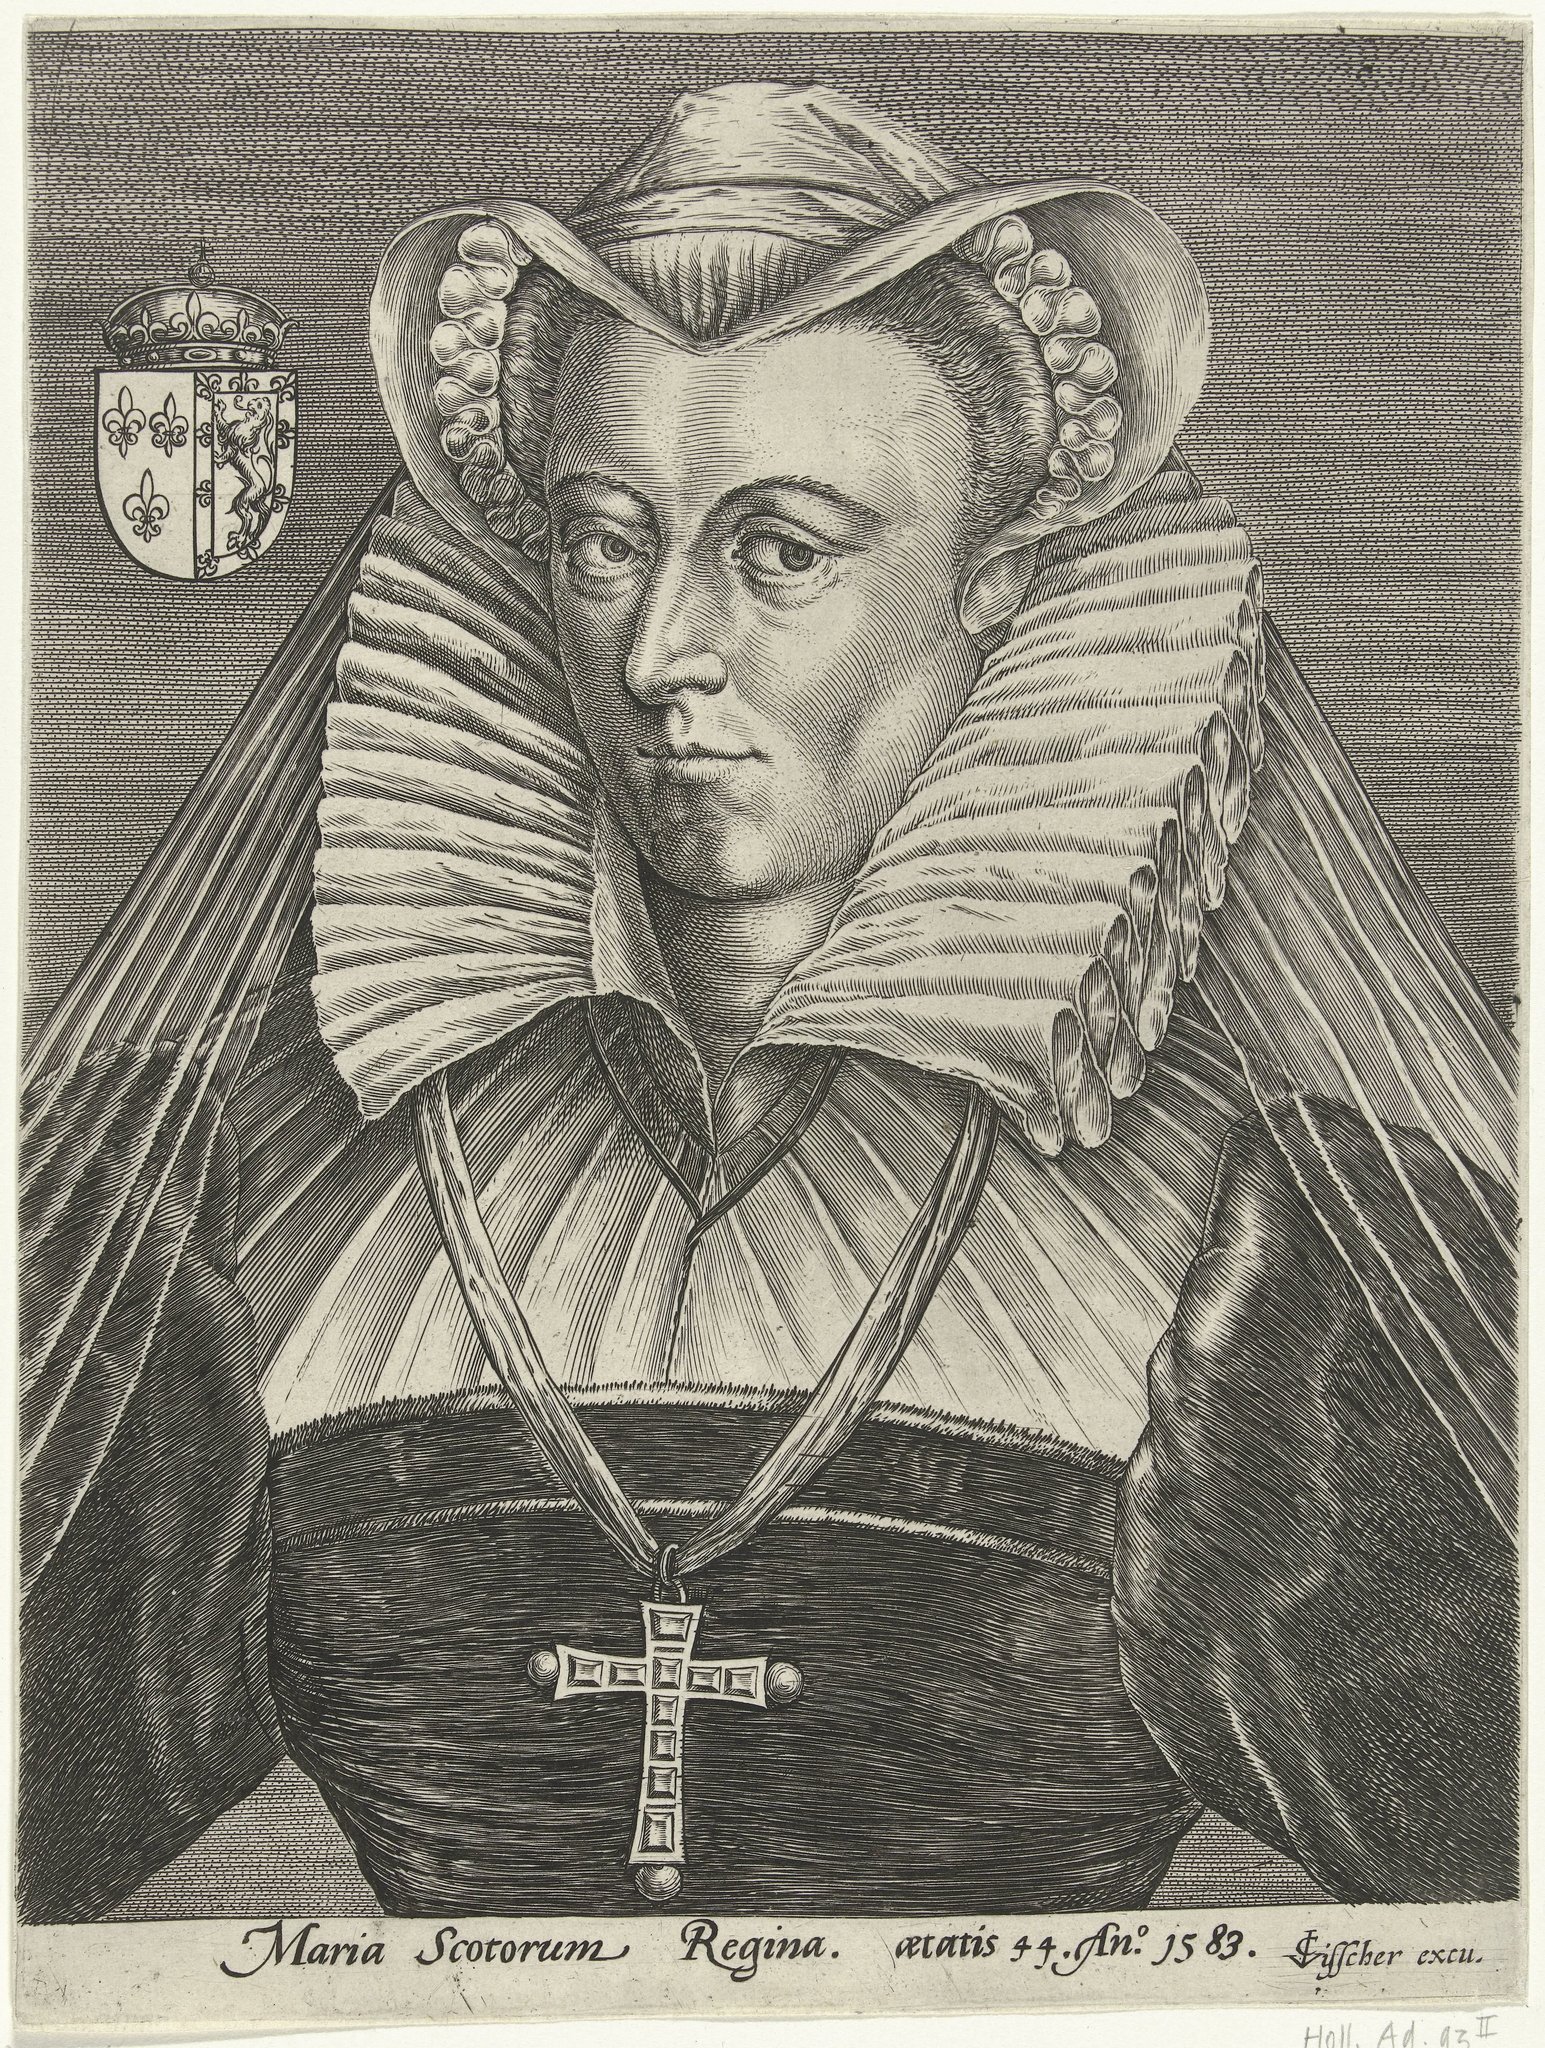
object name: print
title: Portret van Maria I Stuart, koning van Schotland, op 44-jarige leeftijd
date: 1605-1652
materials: paper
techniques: engraving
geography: amsterdam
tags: historical persons - bb - woman, crucifix ~ personal devotion, armorial bearing, heraldry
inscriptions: collector's mark: Lugt 2228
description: Busteportret van Maria I Stuart, koningin van Schotland, naar links met een kruis aan een halssnoer op haar borst. Links haar wapen.